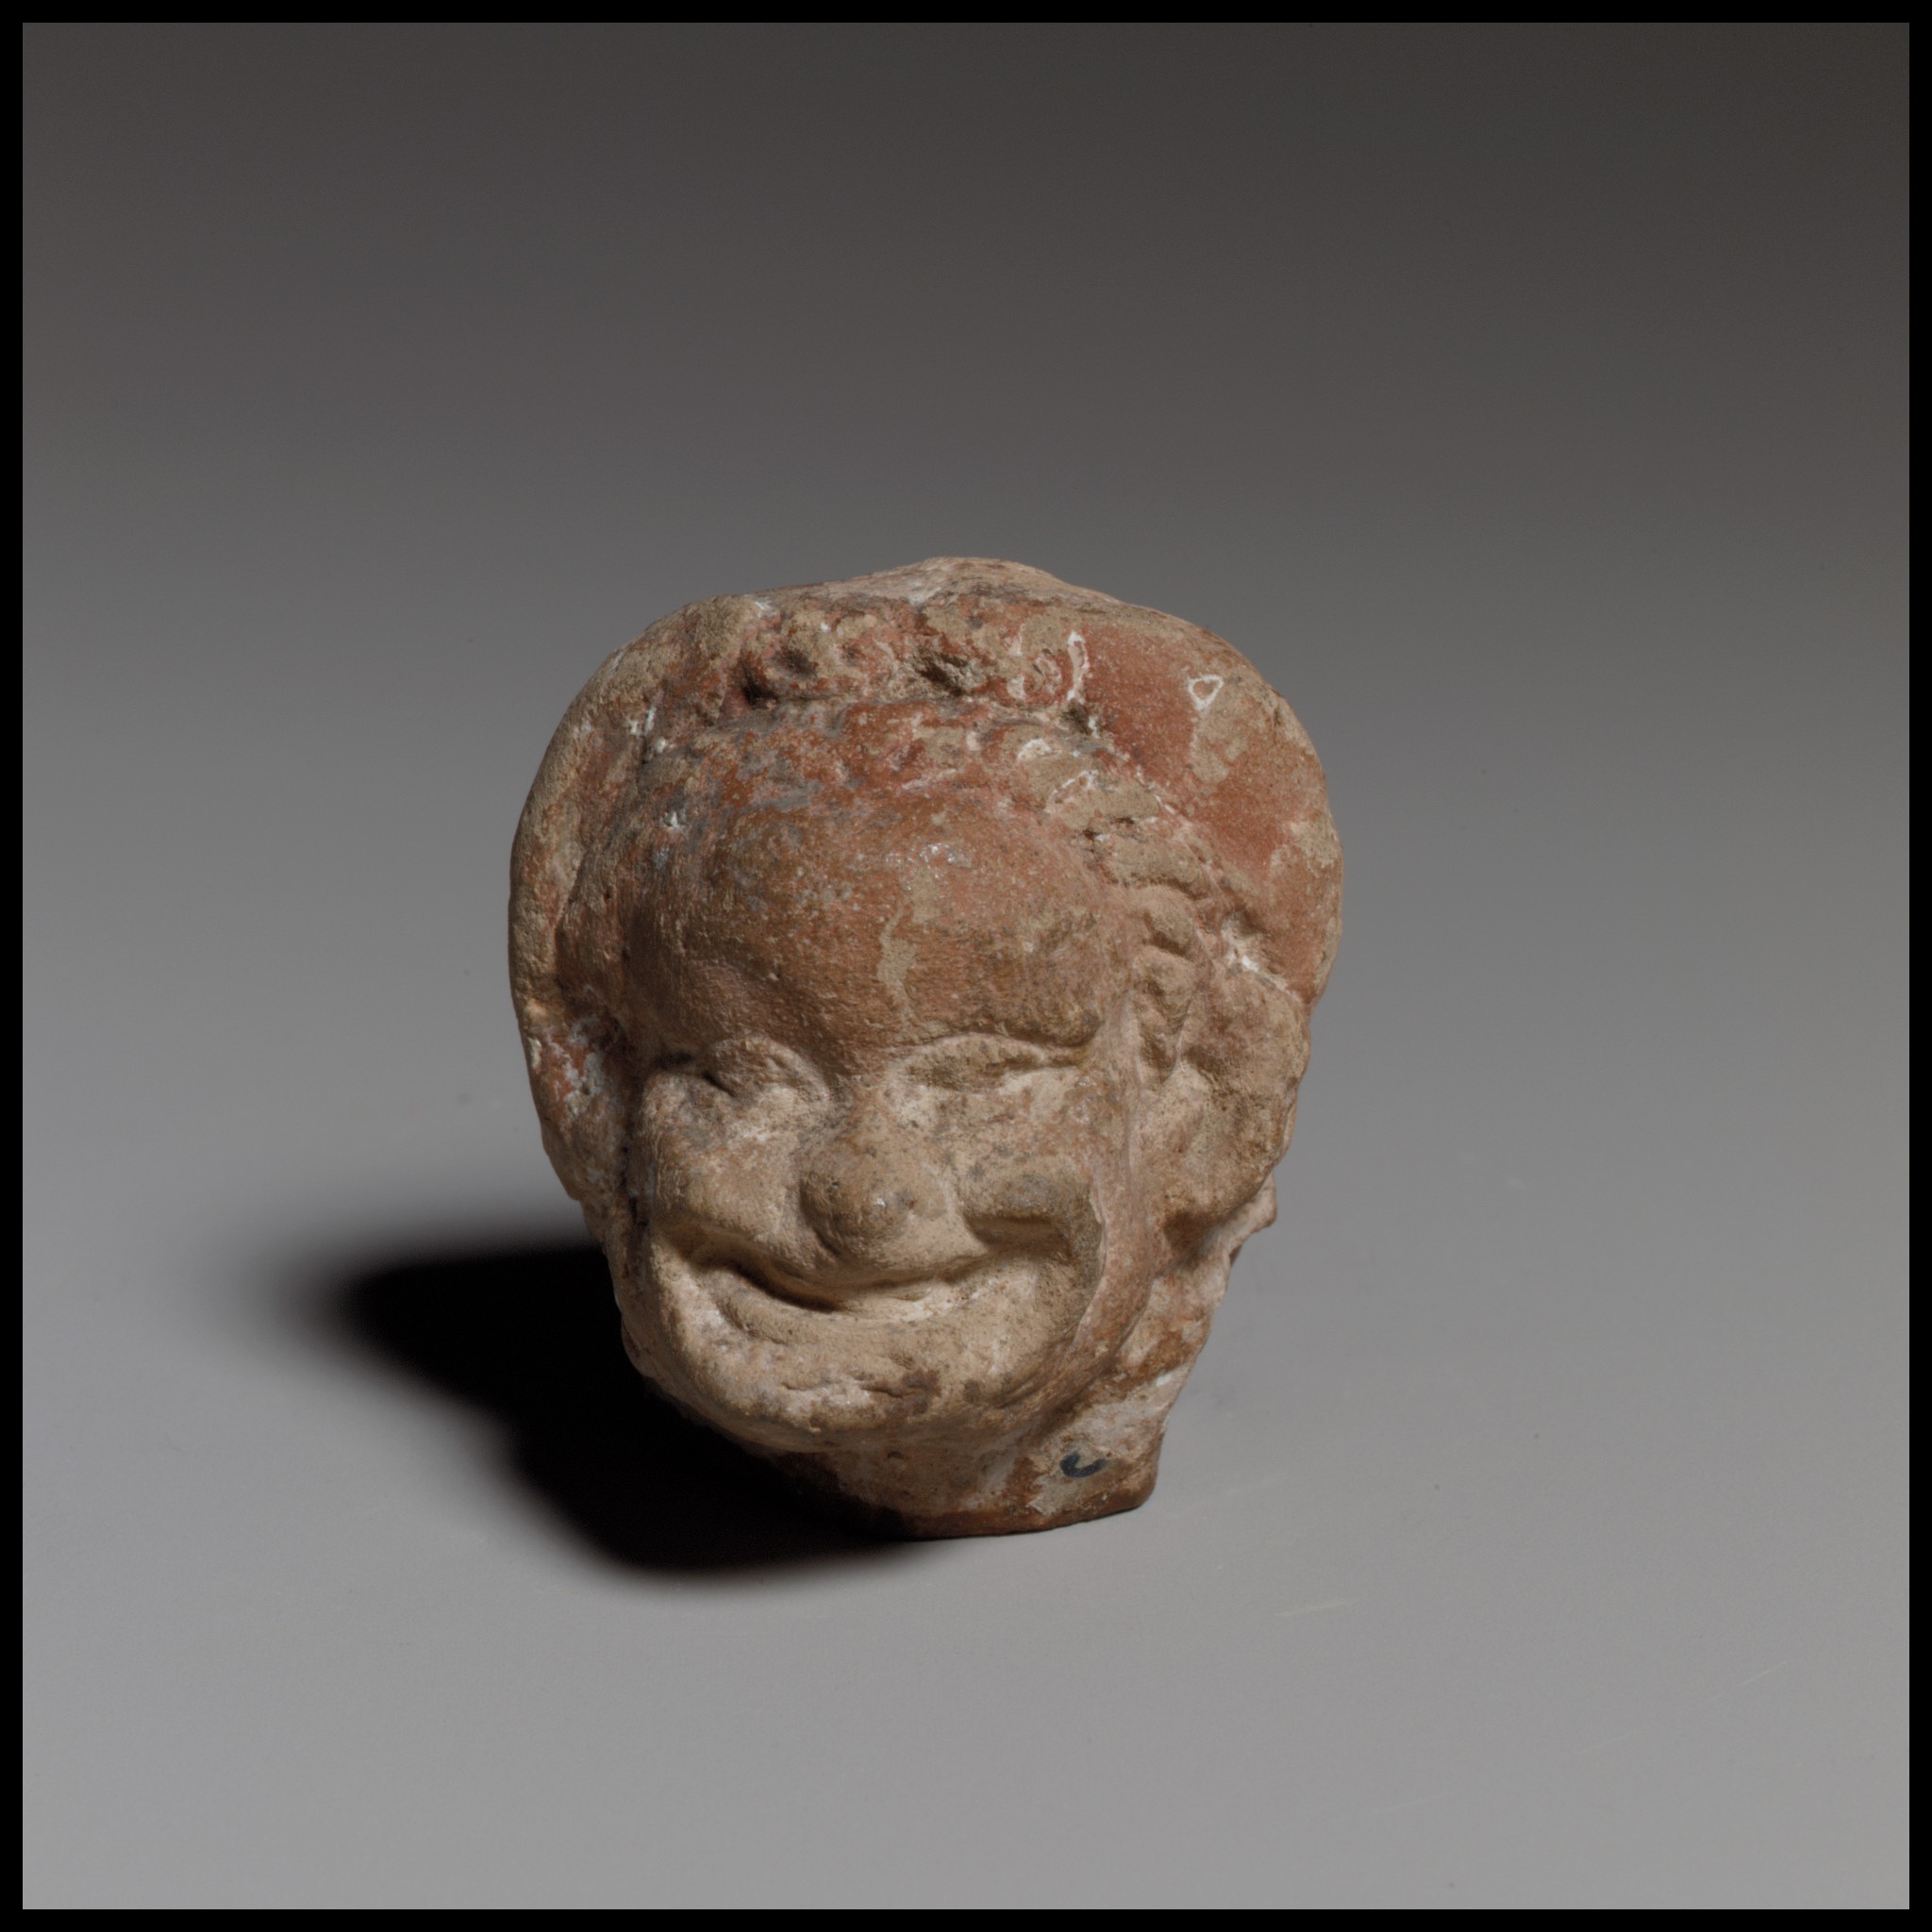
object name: head of a figurine, comic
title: Head of a comic figurine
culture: greek, attic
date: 334-201 BCE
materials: terracotta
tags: heads